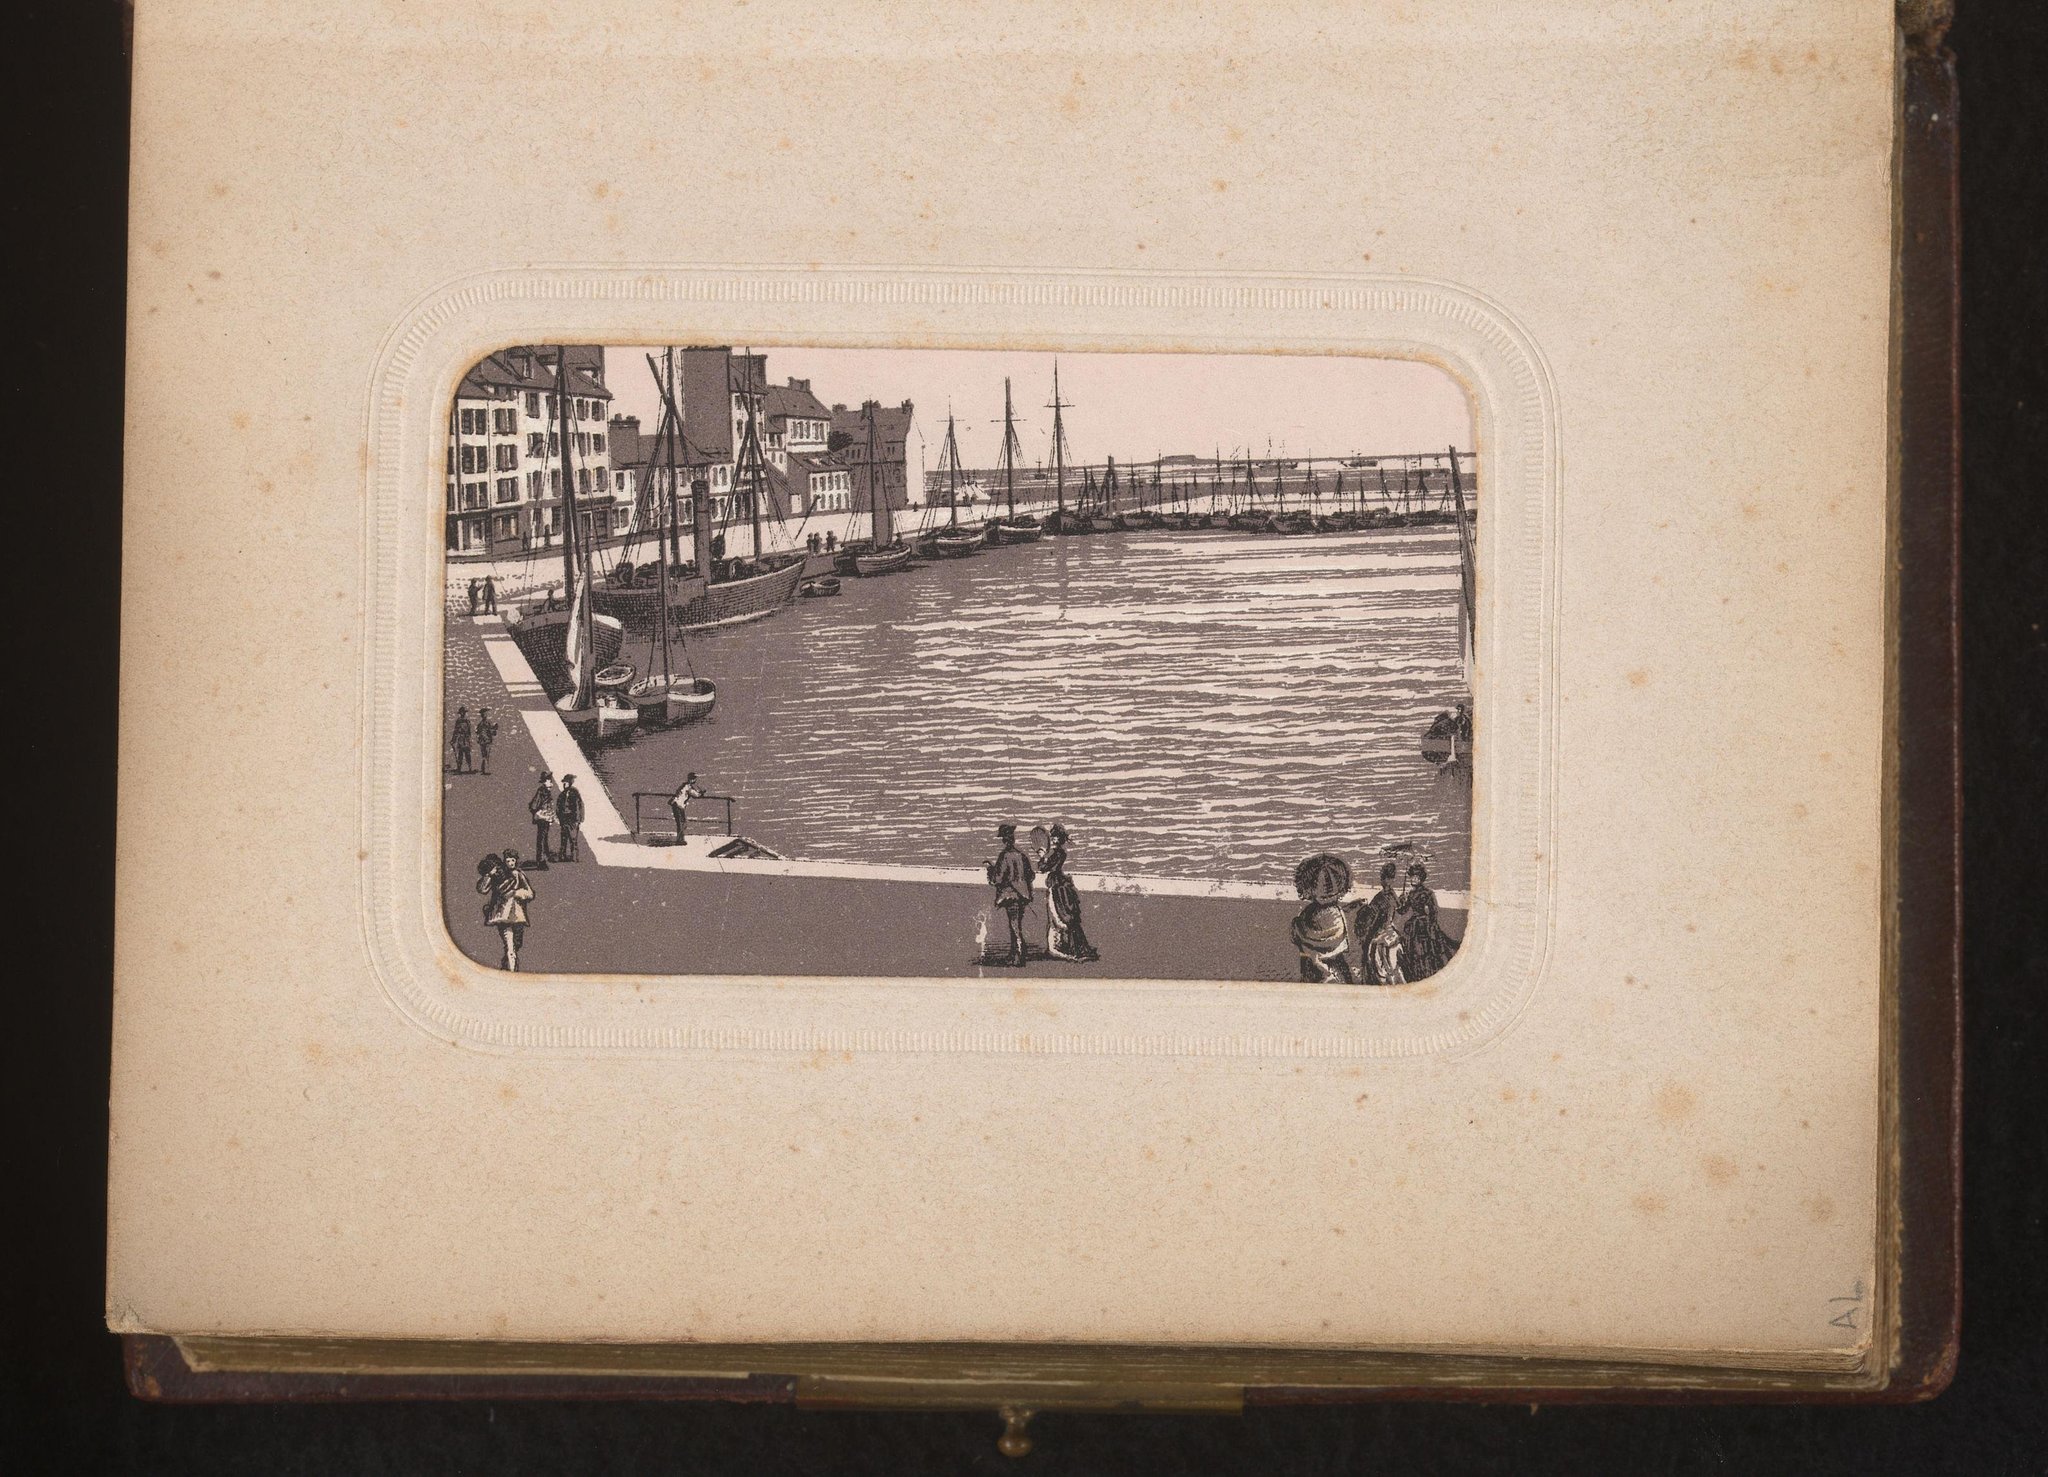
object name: print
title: Gezicht op de haven van Caligny, Frankrijk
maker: Anonymous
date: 1860-1900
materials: cardboard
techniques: lithograph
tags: harbour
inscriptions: inscription: ‘[...] PORT ET LE QUAI DE CALIGNY.’